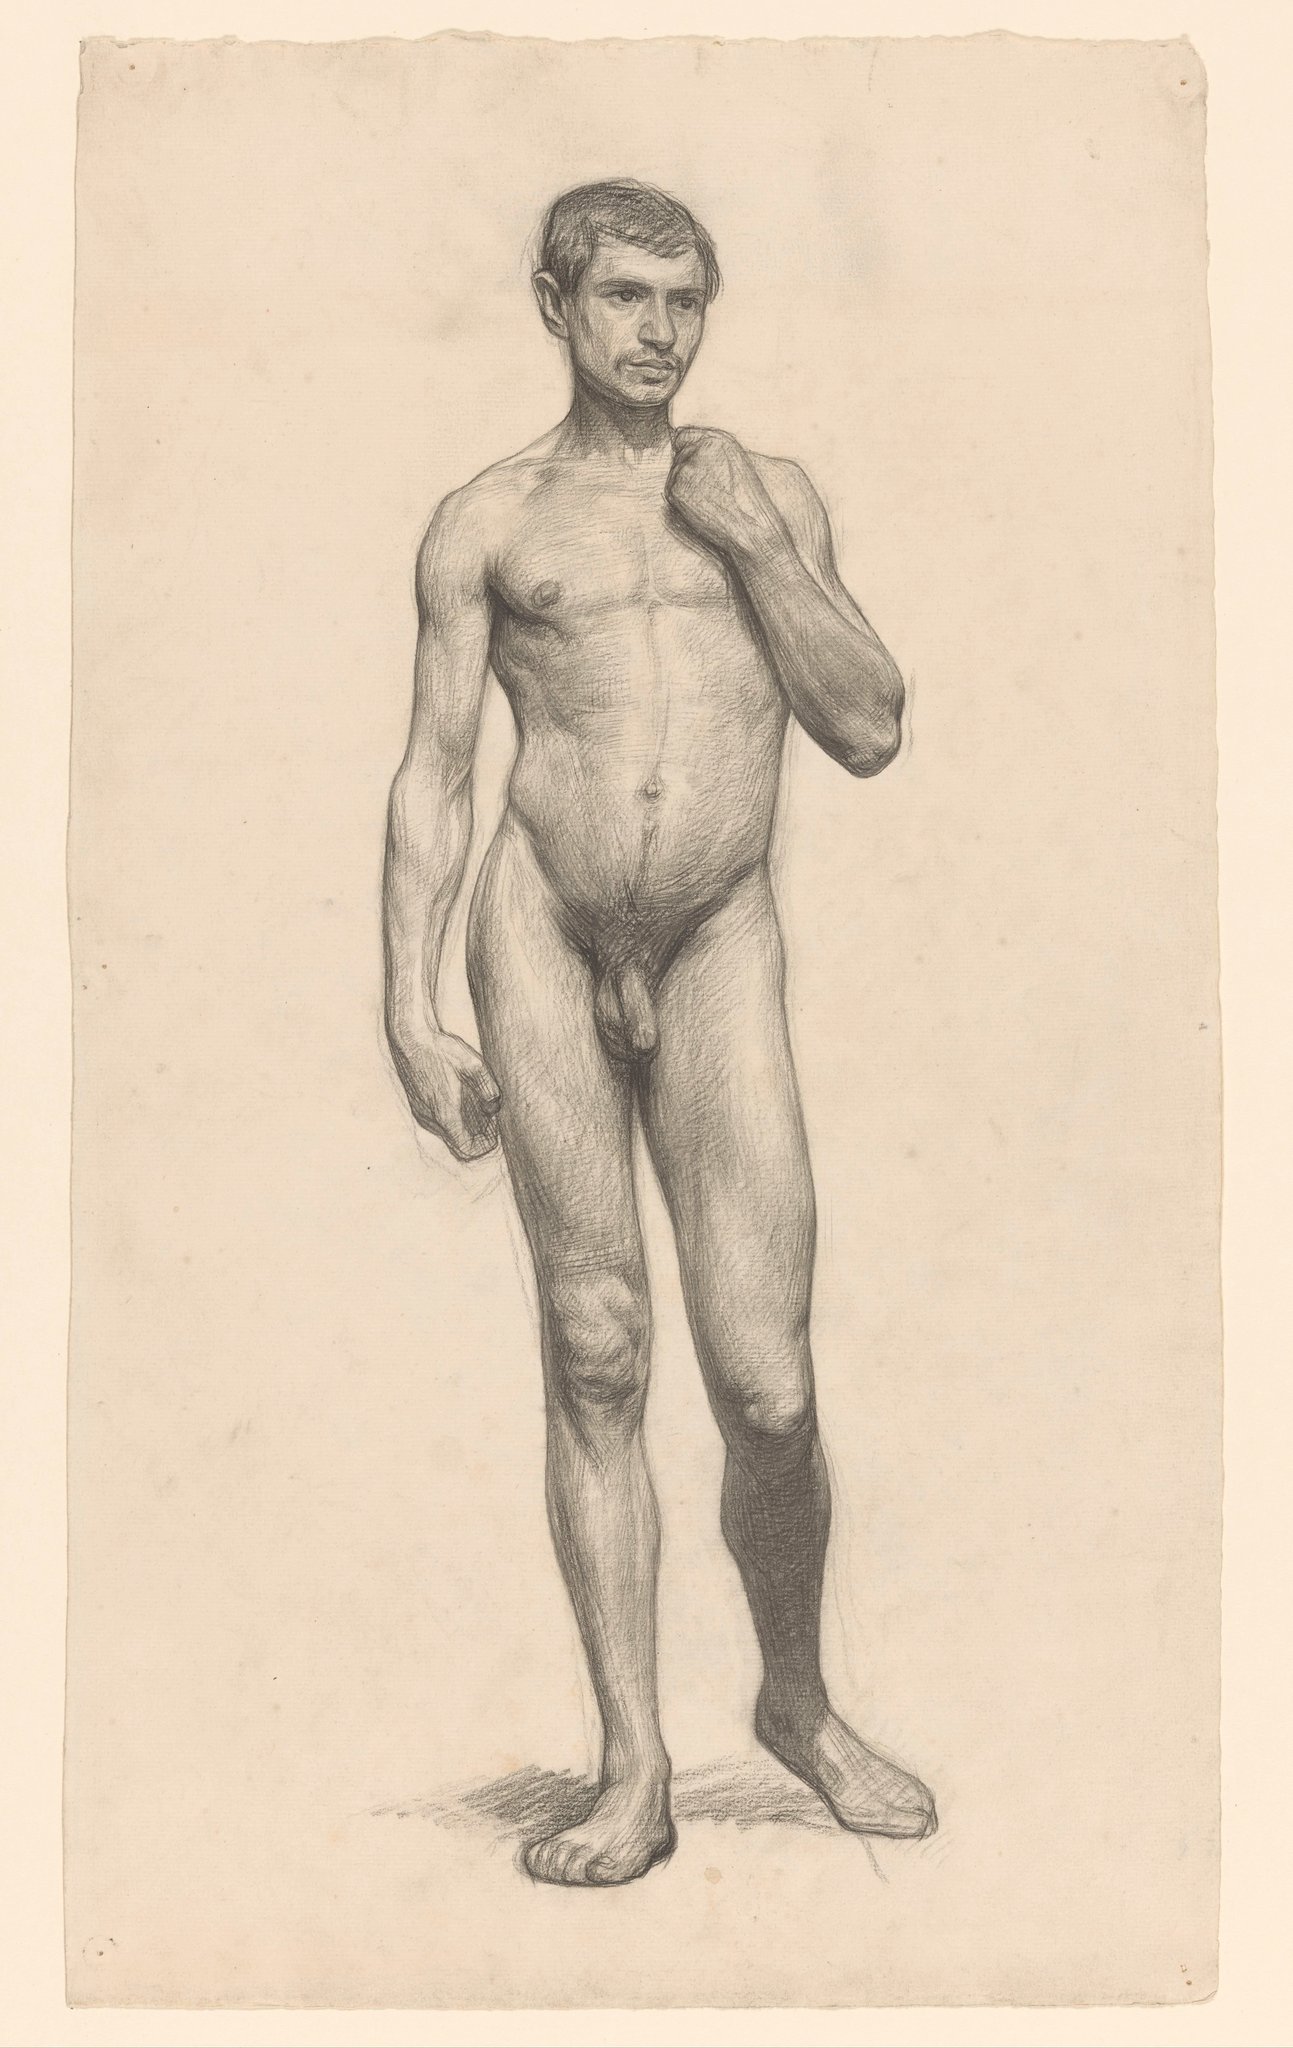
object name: drawing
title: Staand mannelijk naakt, van voren gezien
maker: jan veth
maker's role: designer, draughtsman, painter, print maker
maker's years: 1864-1925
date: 1874-1925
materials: chalk, paper